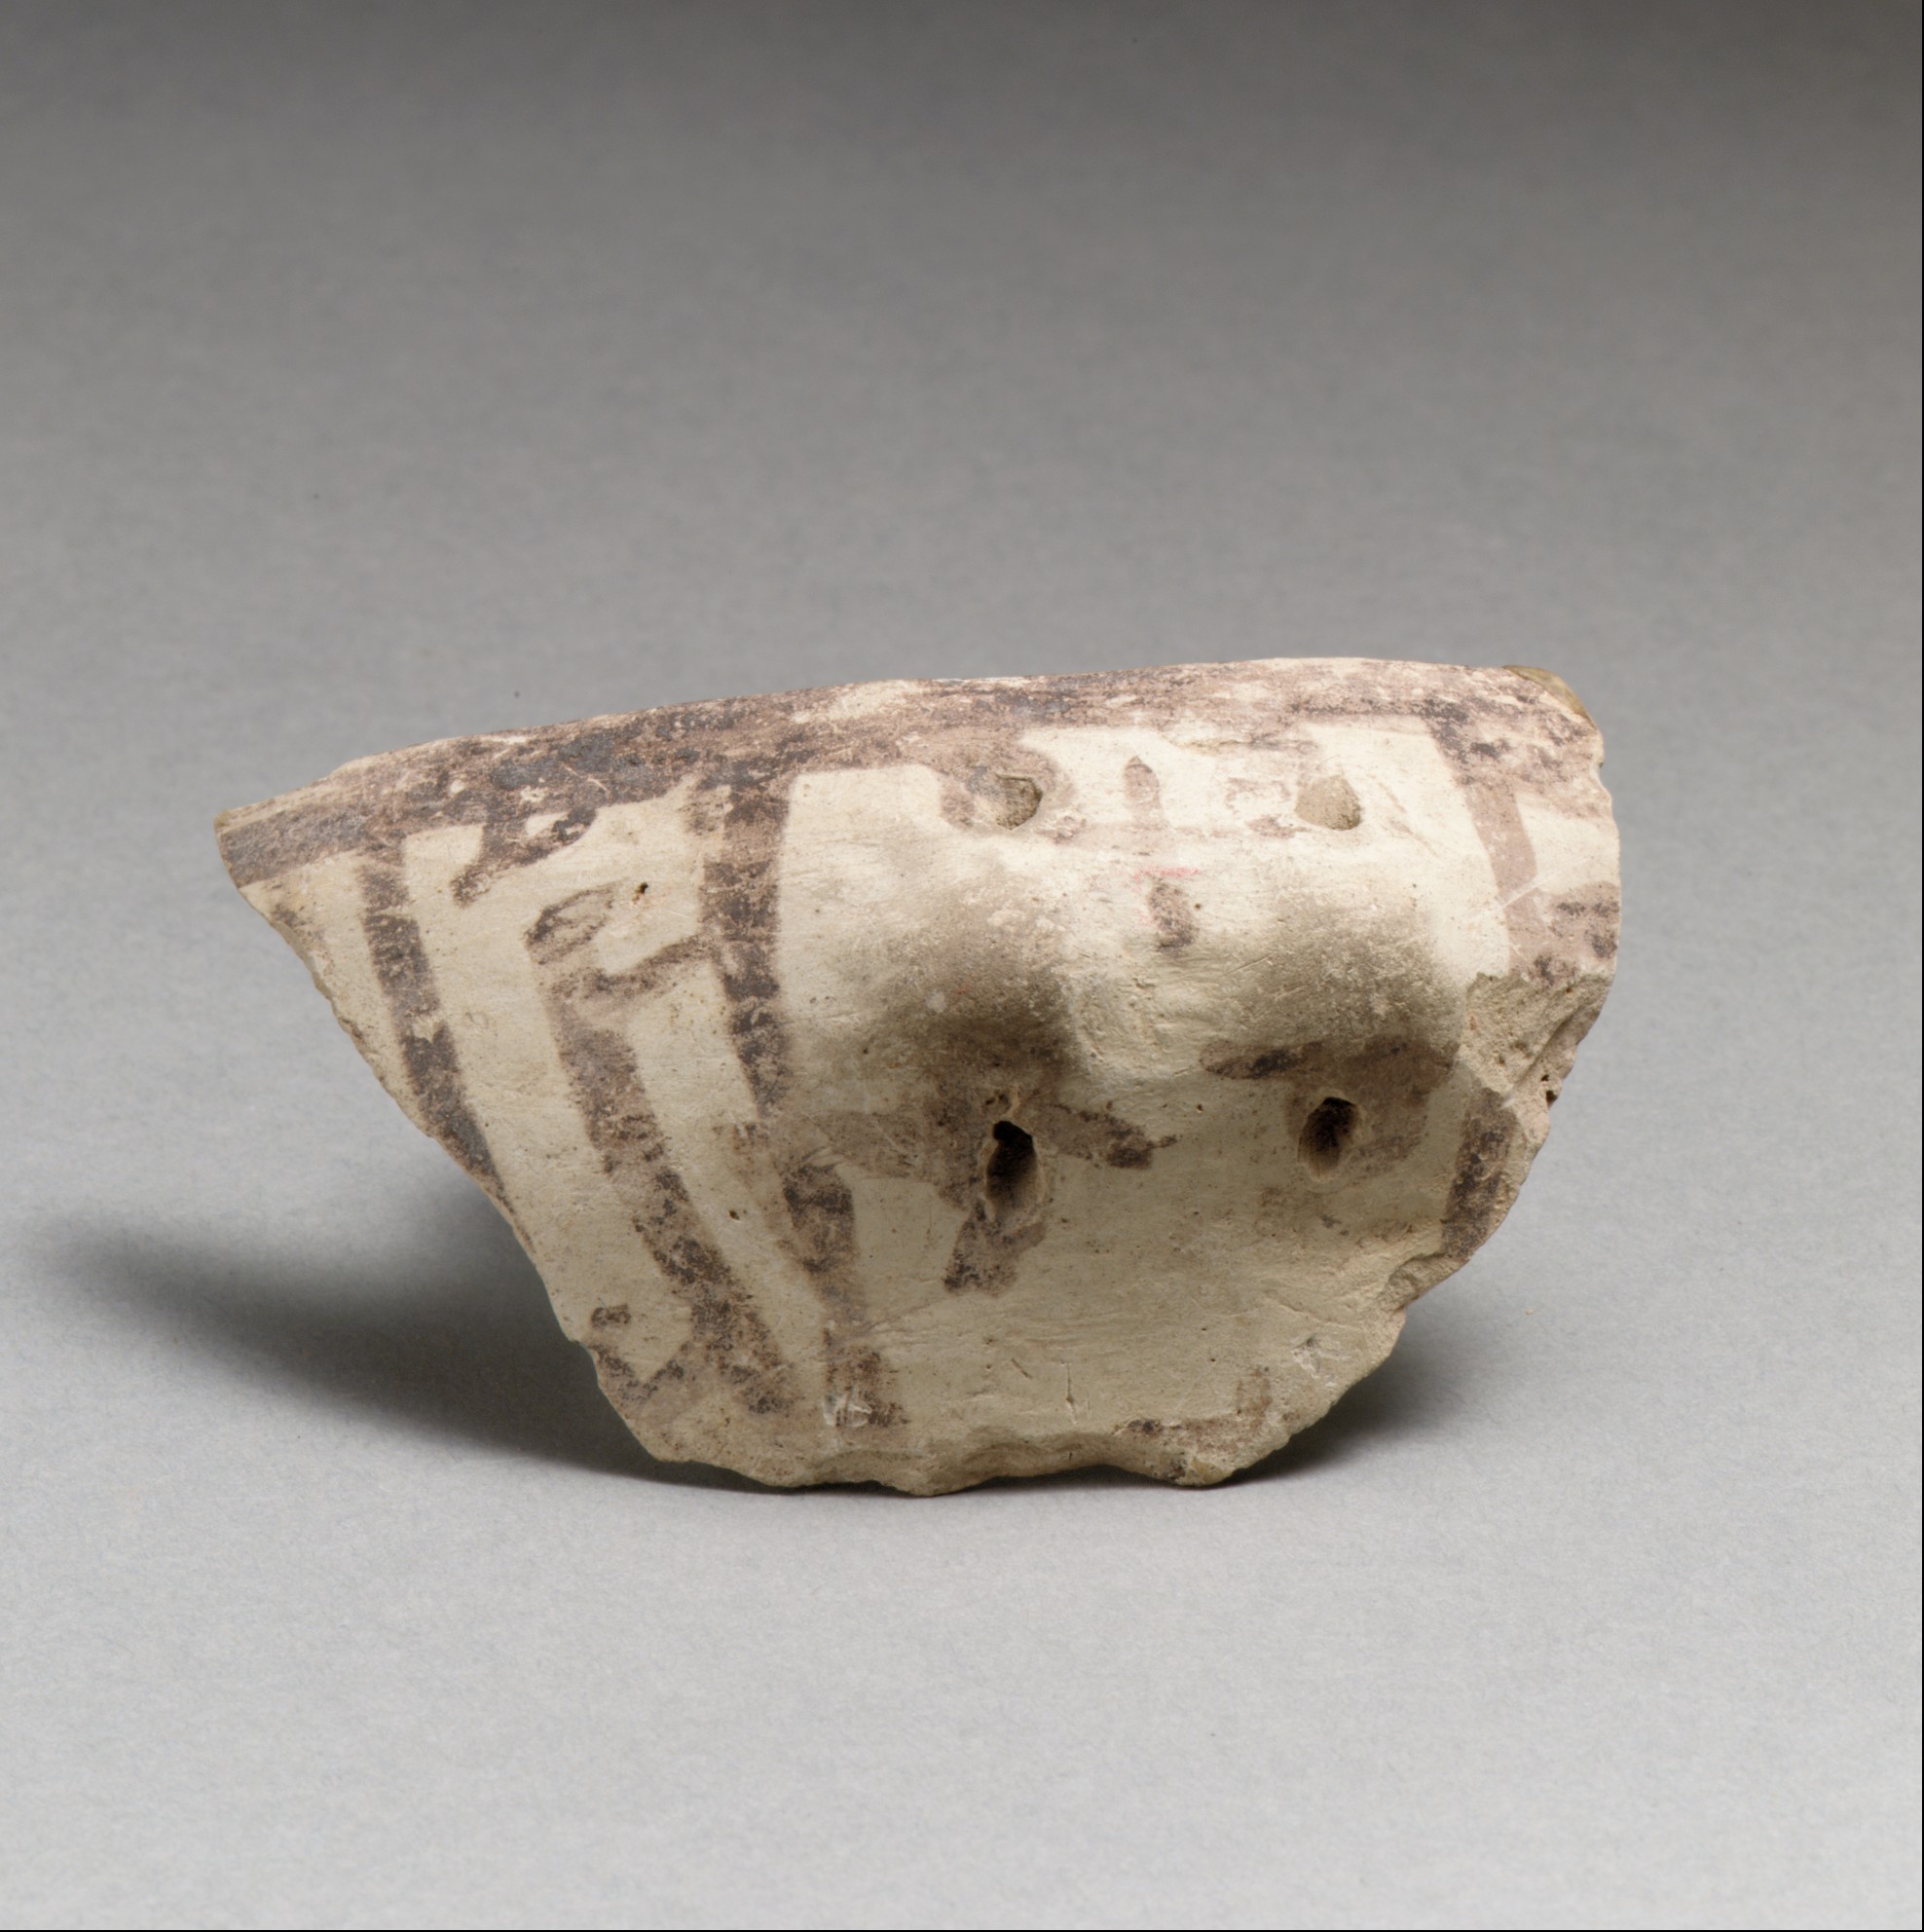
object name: vase fragment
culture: neolithic, thessaly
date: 4000-3000 BCE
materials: terracotta